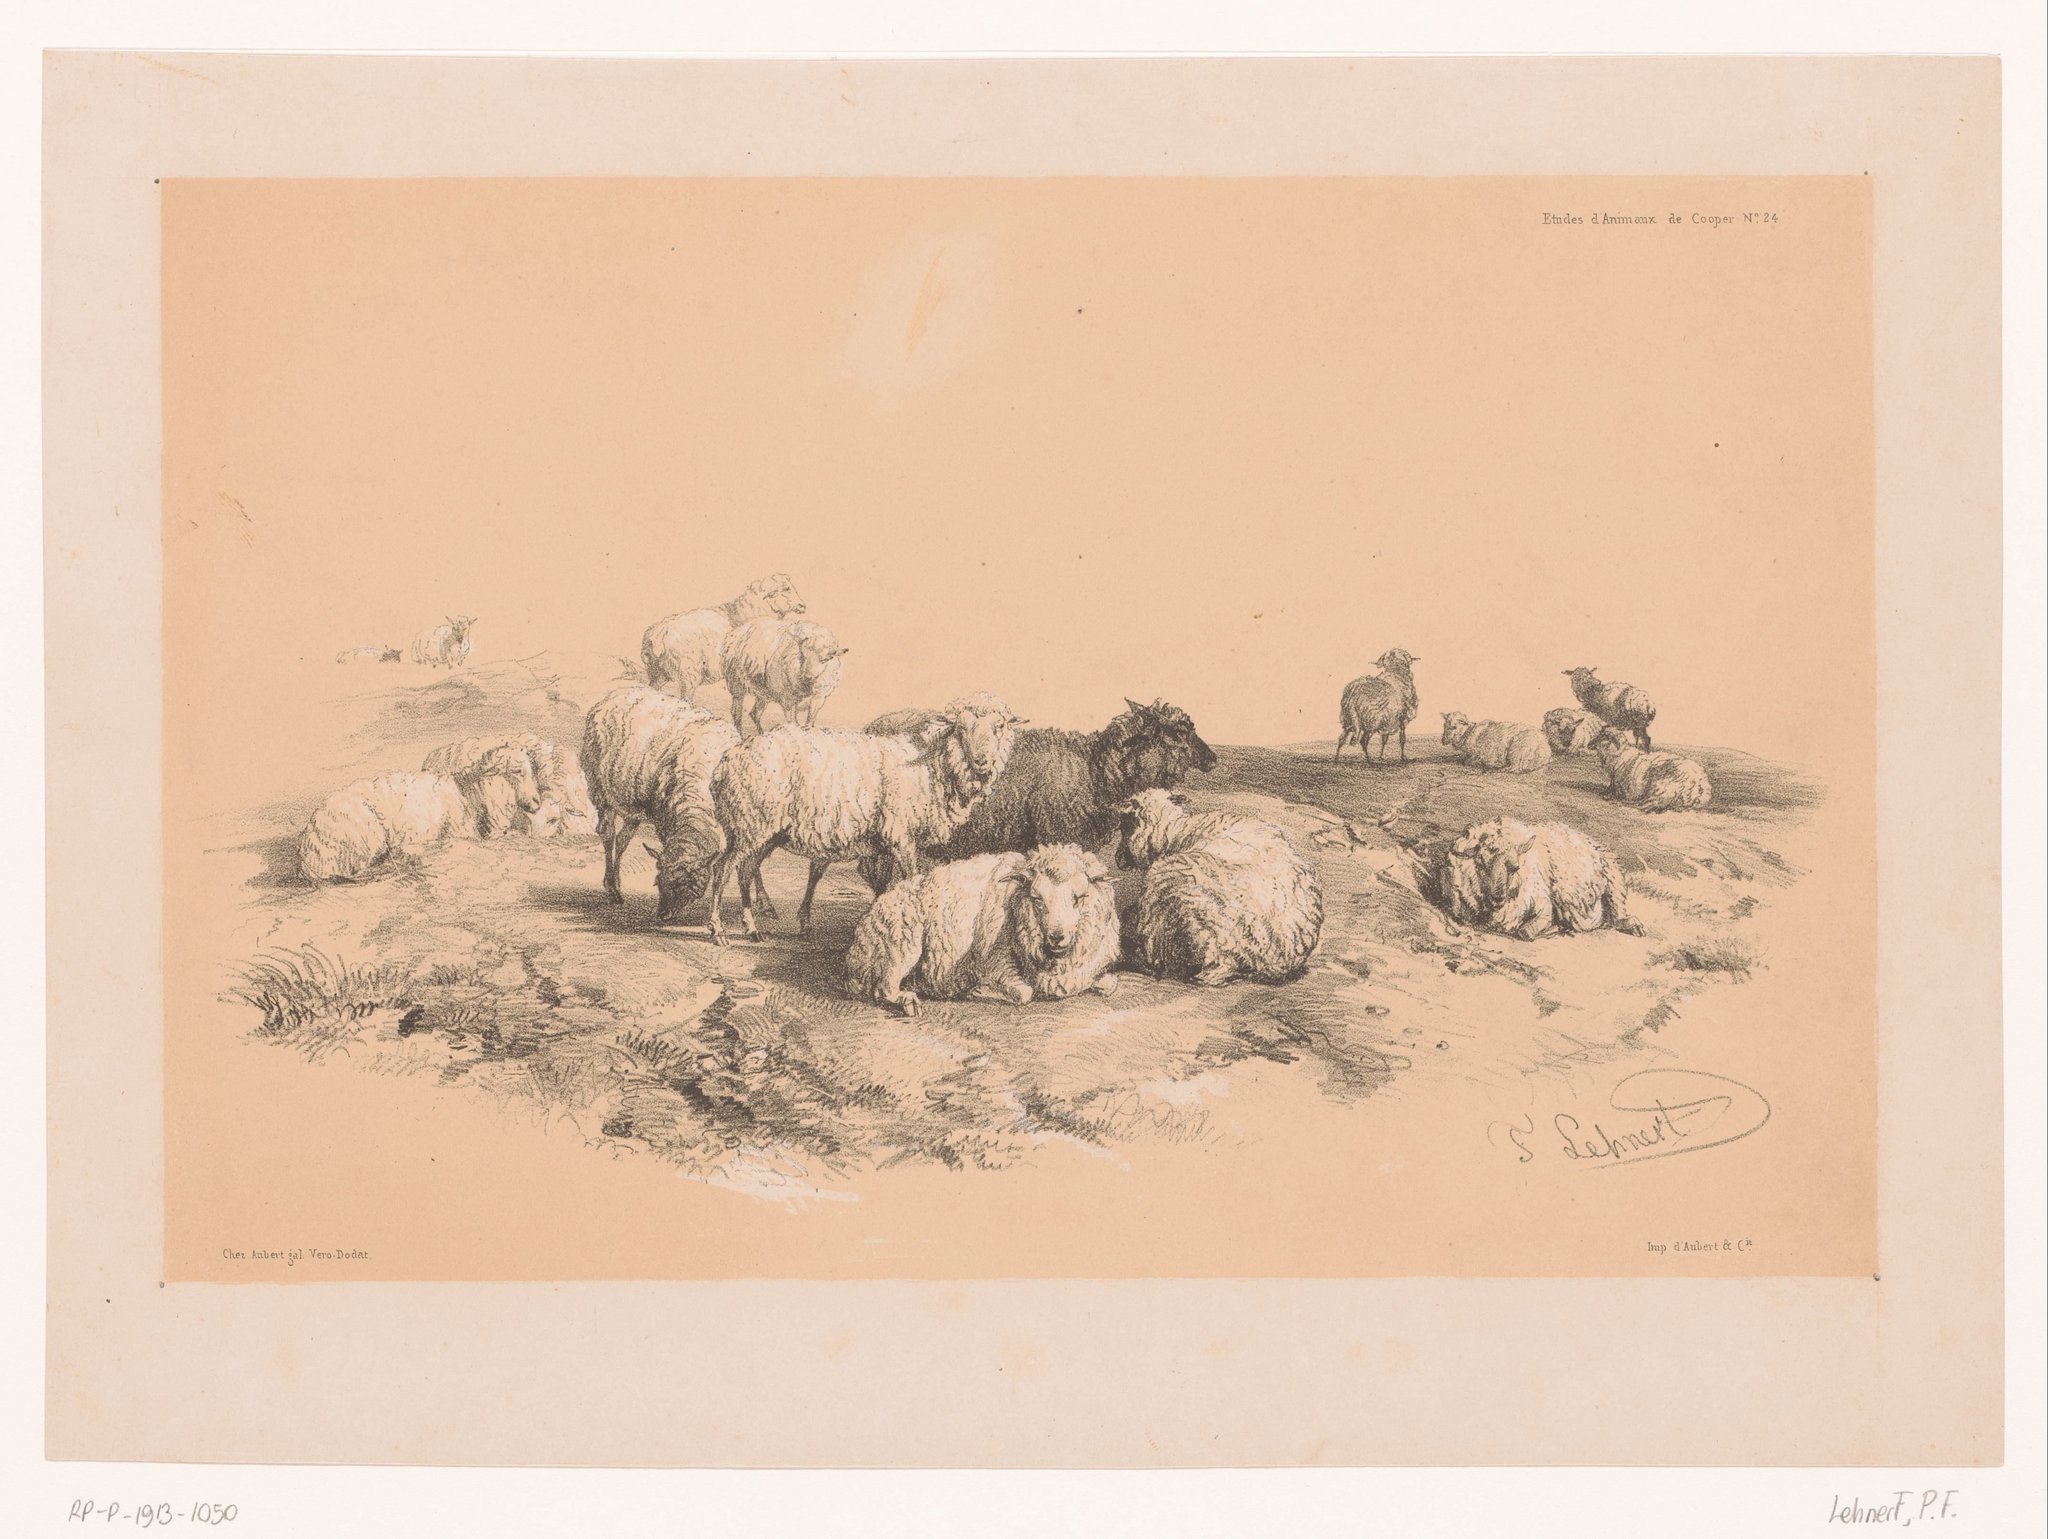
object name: print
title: Dierstudies van Cooper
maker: pierre frédéric lehnert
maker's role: print maker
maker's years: 1811-1880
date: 1838-1840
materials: paper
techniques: tone lithography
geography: paris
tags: sheep, herd, flock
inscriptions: collector's mark: Lugt 2228a